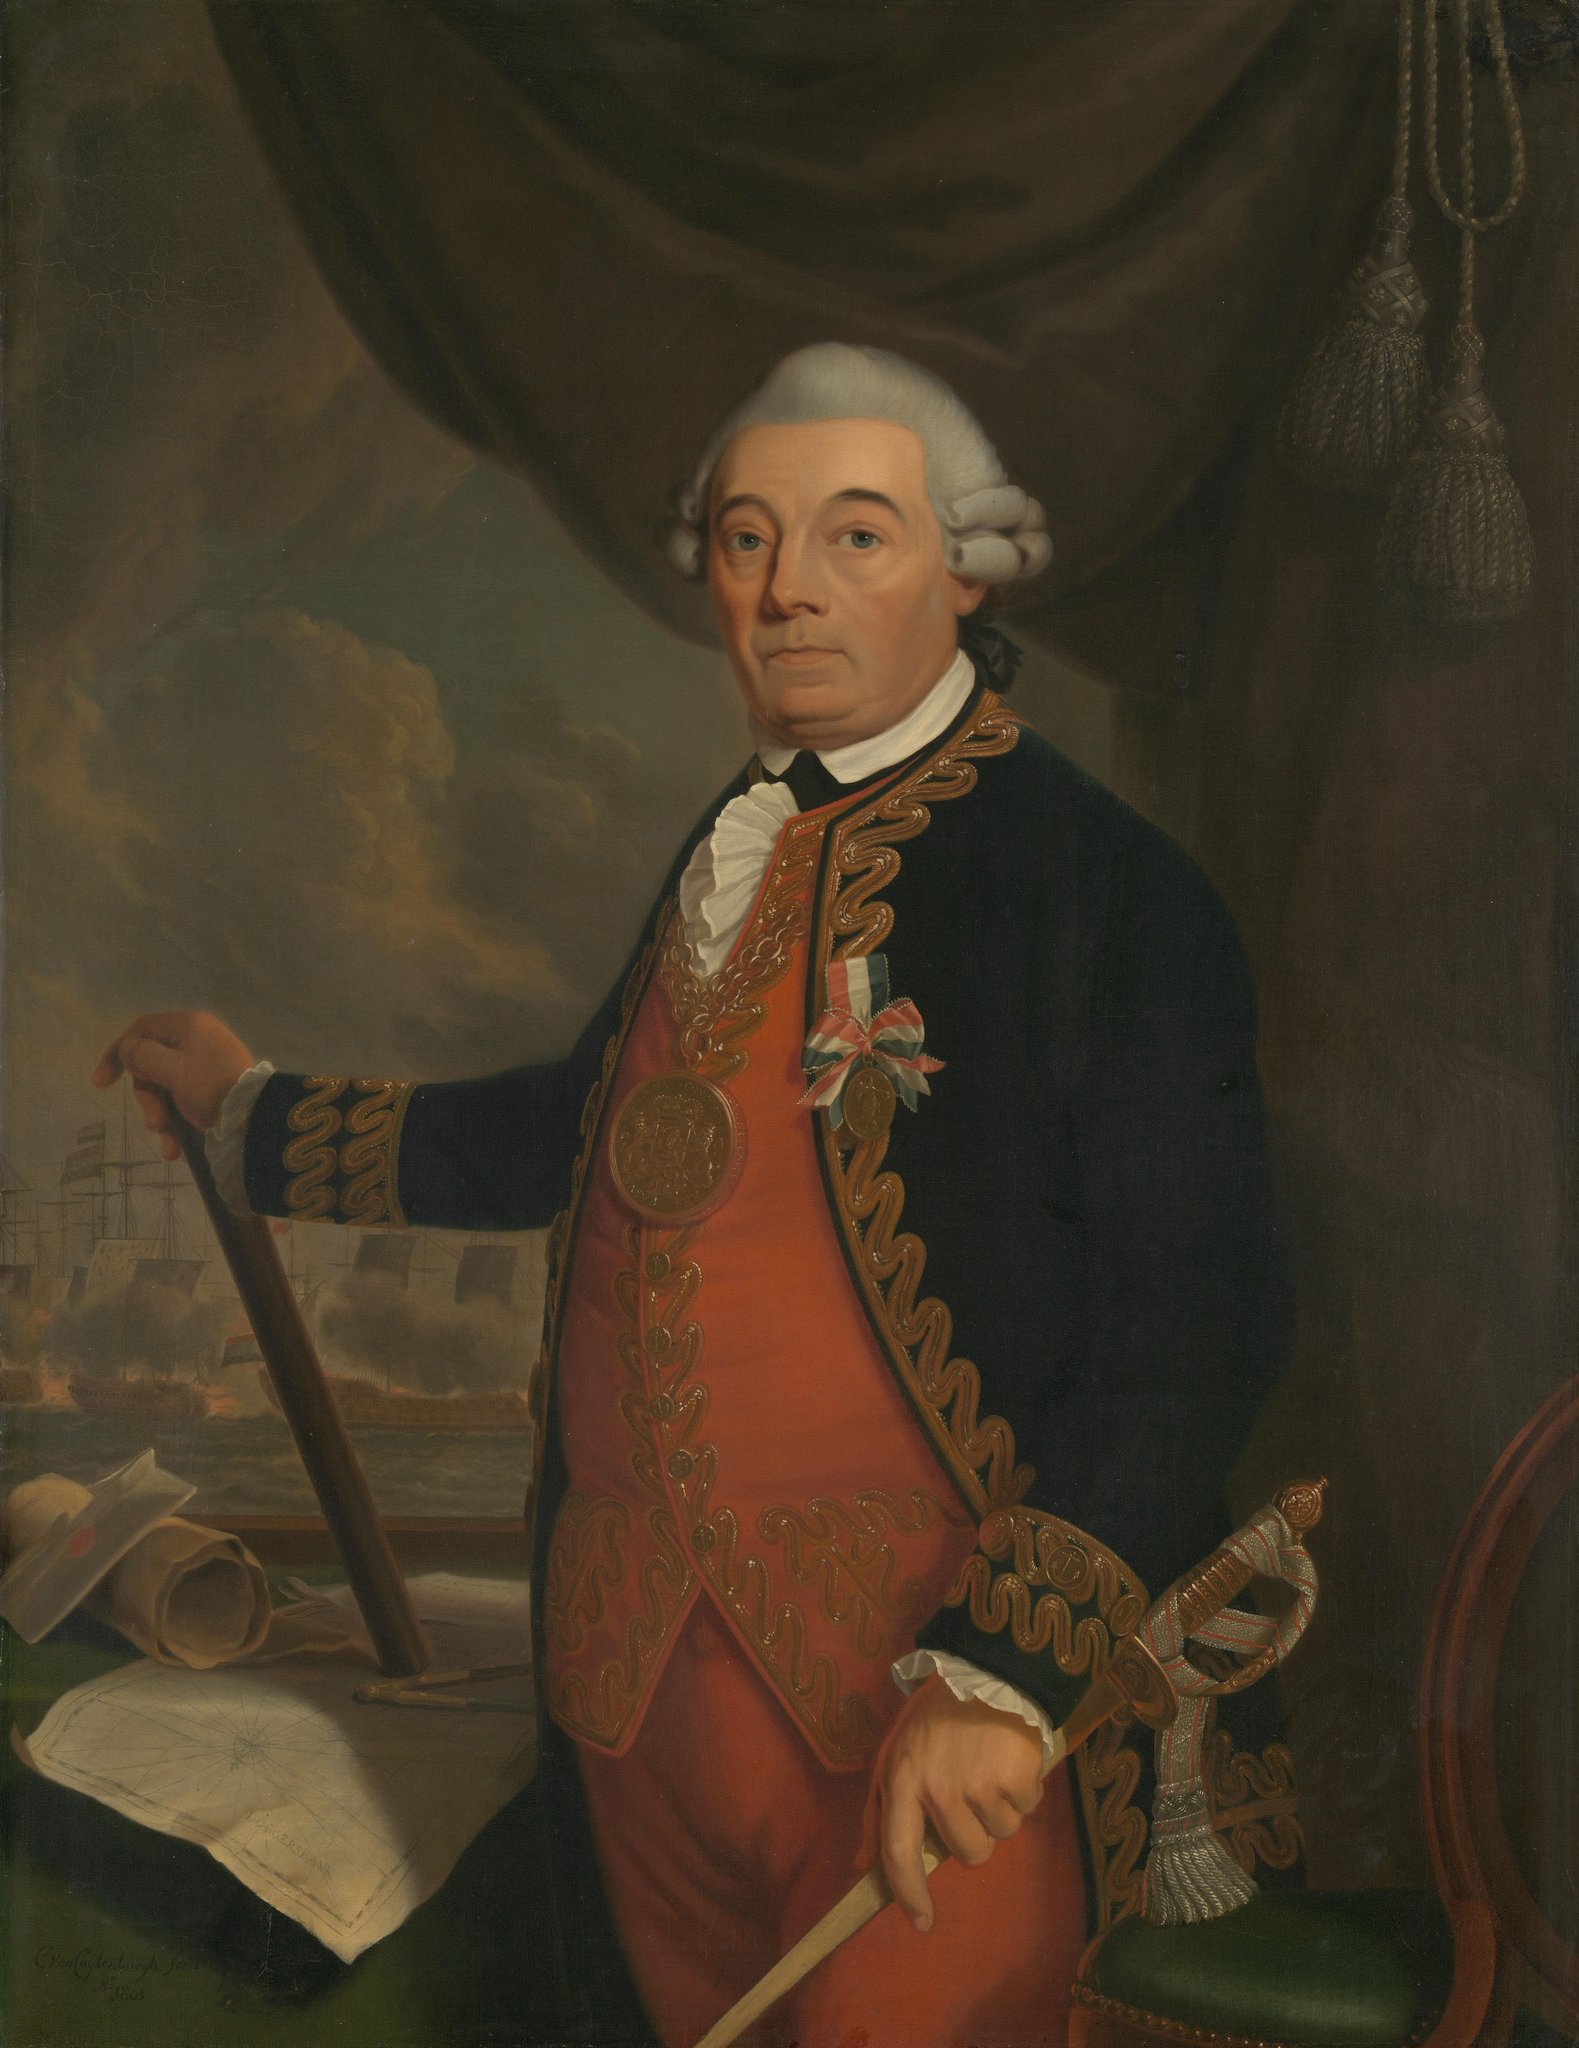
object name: painting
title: Portrait of Johan Arnold Zoutman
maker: cornelis van cuijlenburgh (ii)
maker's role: painter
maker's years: 1758-1827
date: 1801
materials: canvas, oil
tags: johan arnold zoutman, battle (+ naval force), historical persons, baton of general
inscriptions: signature and date: ‘C. van Cuylenburgh fecit Aº 1801’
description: The undecided naval Battle of Dogger Bank in the North Sea against the British (1781) was celebrated as a victory in the Dutch Republic. Under the command of Vice-Admiral Zoutman, the Dutch fleet had finally regained its militancy. Zoutman is portrayed with the decorations he received in gratitude from Stadtholder William V: a gold sword, a Dogger Bank medallion on a ribbon and a medal of honour.